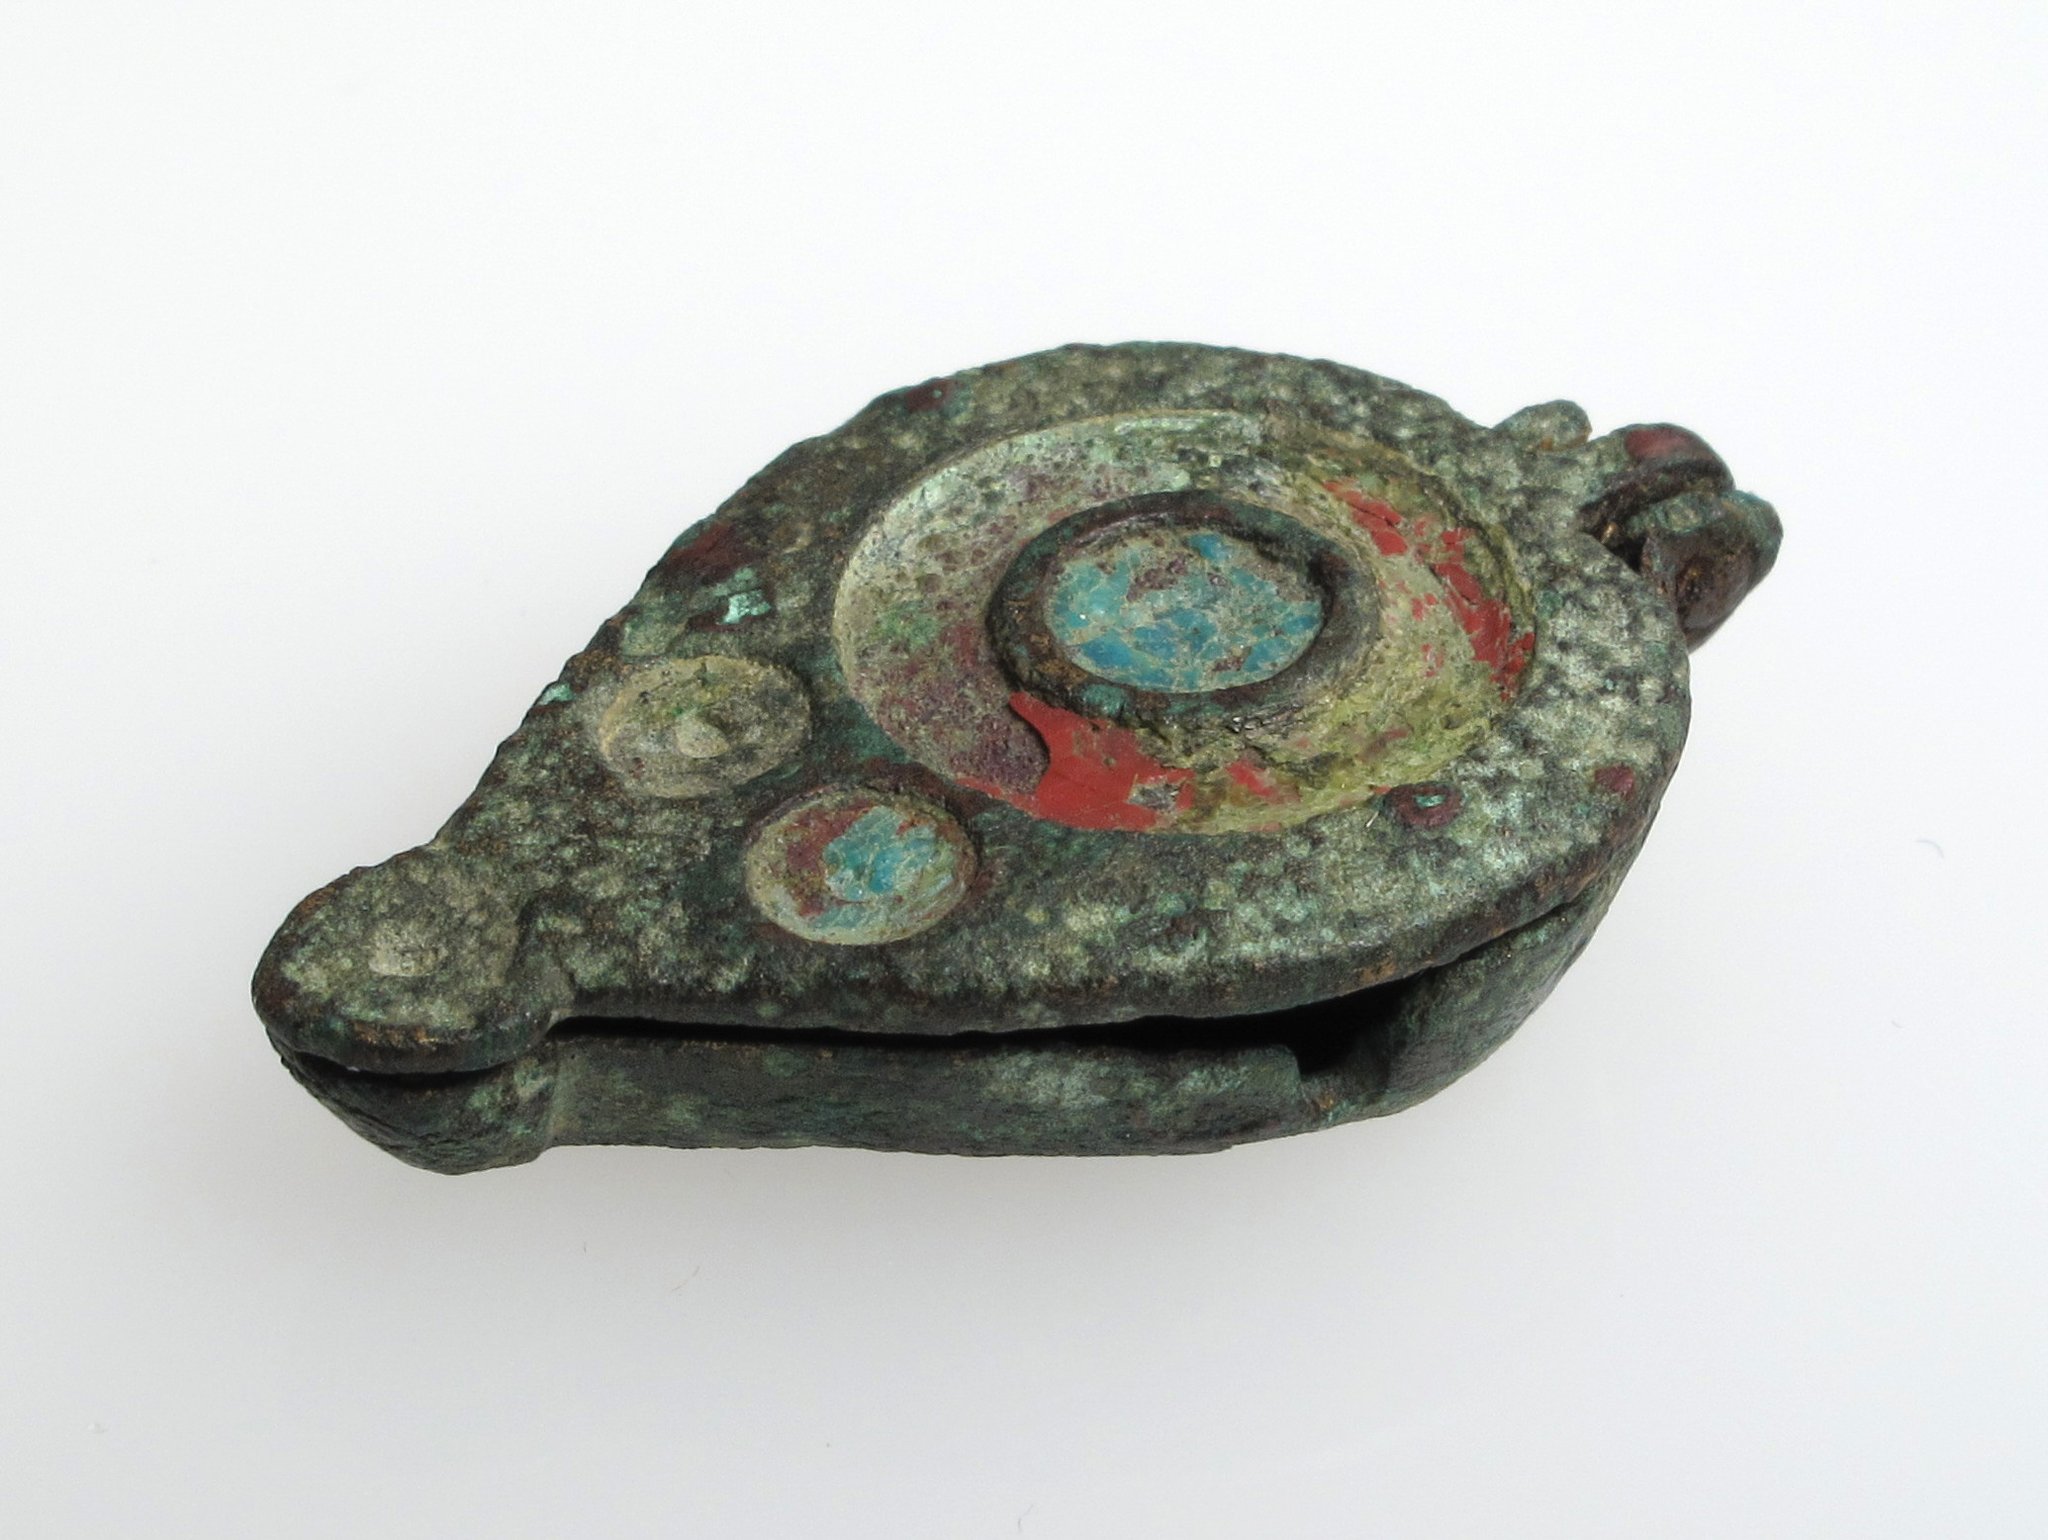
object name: seal box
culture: roman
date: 201-300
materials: bronze, enamel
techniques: enamel